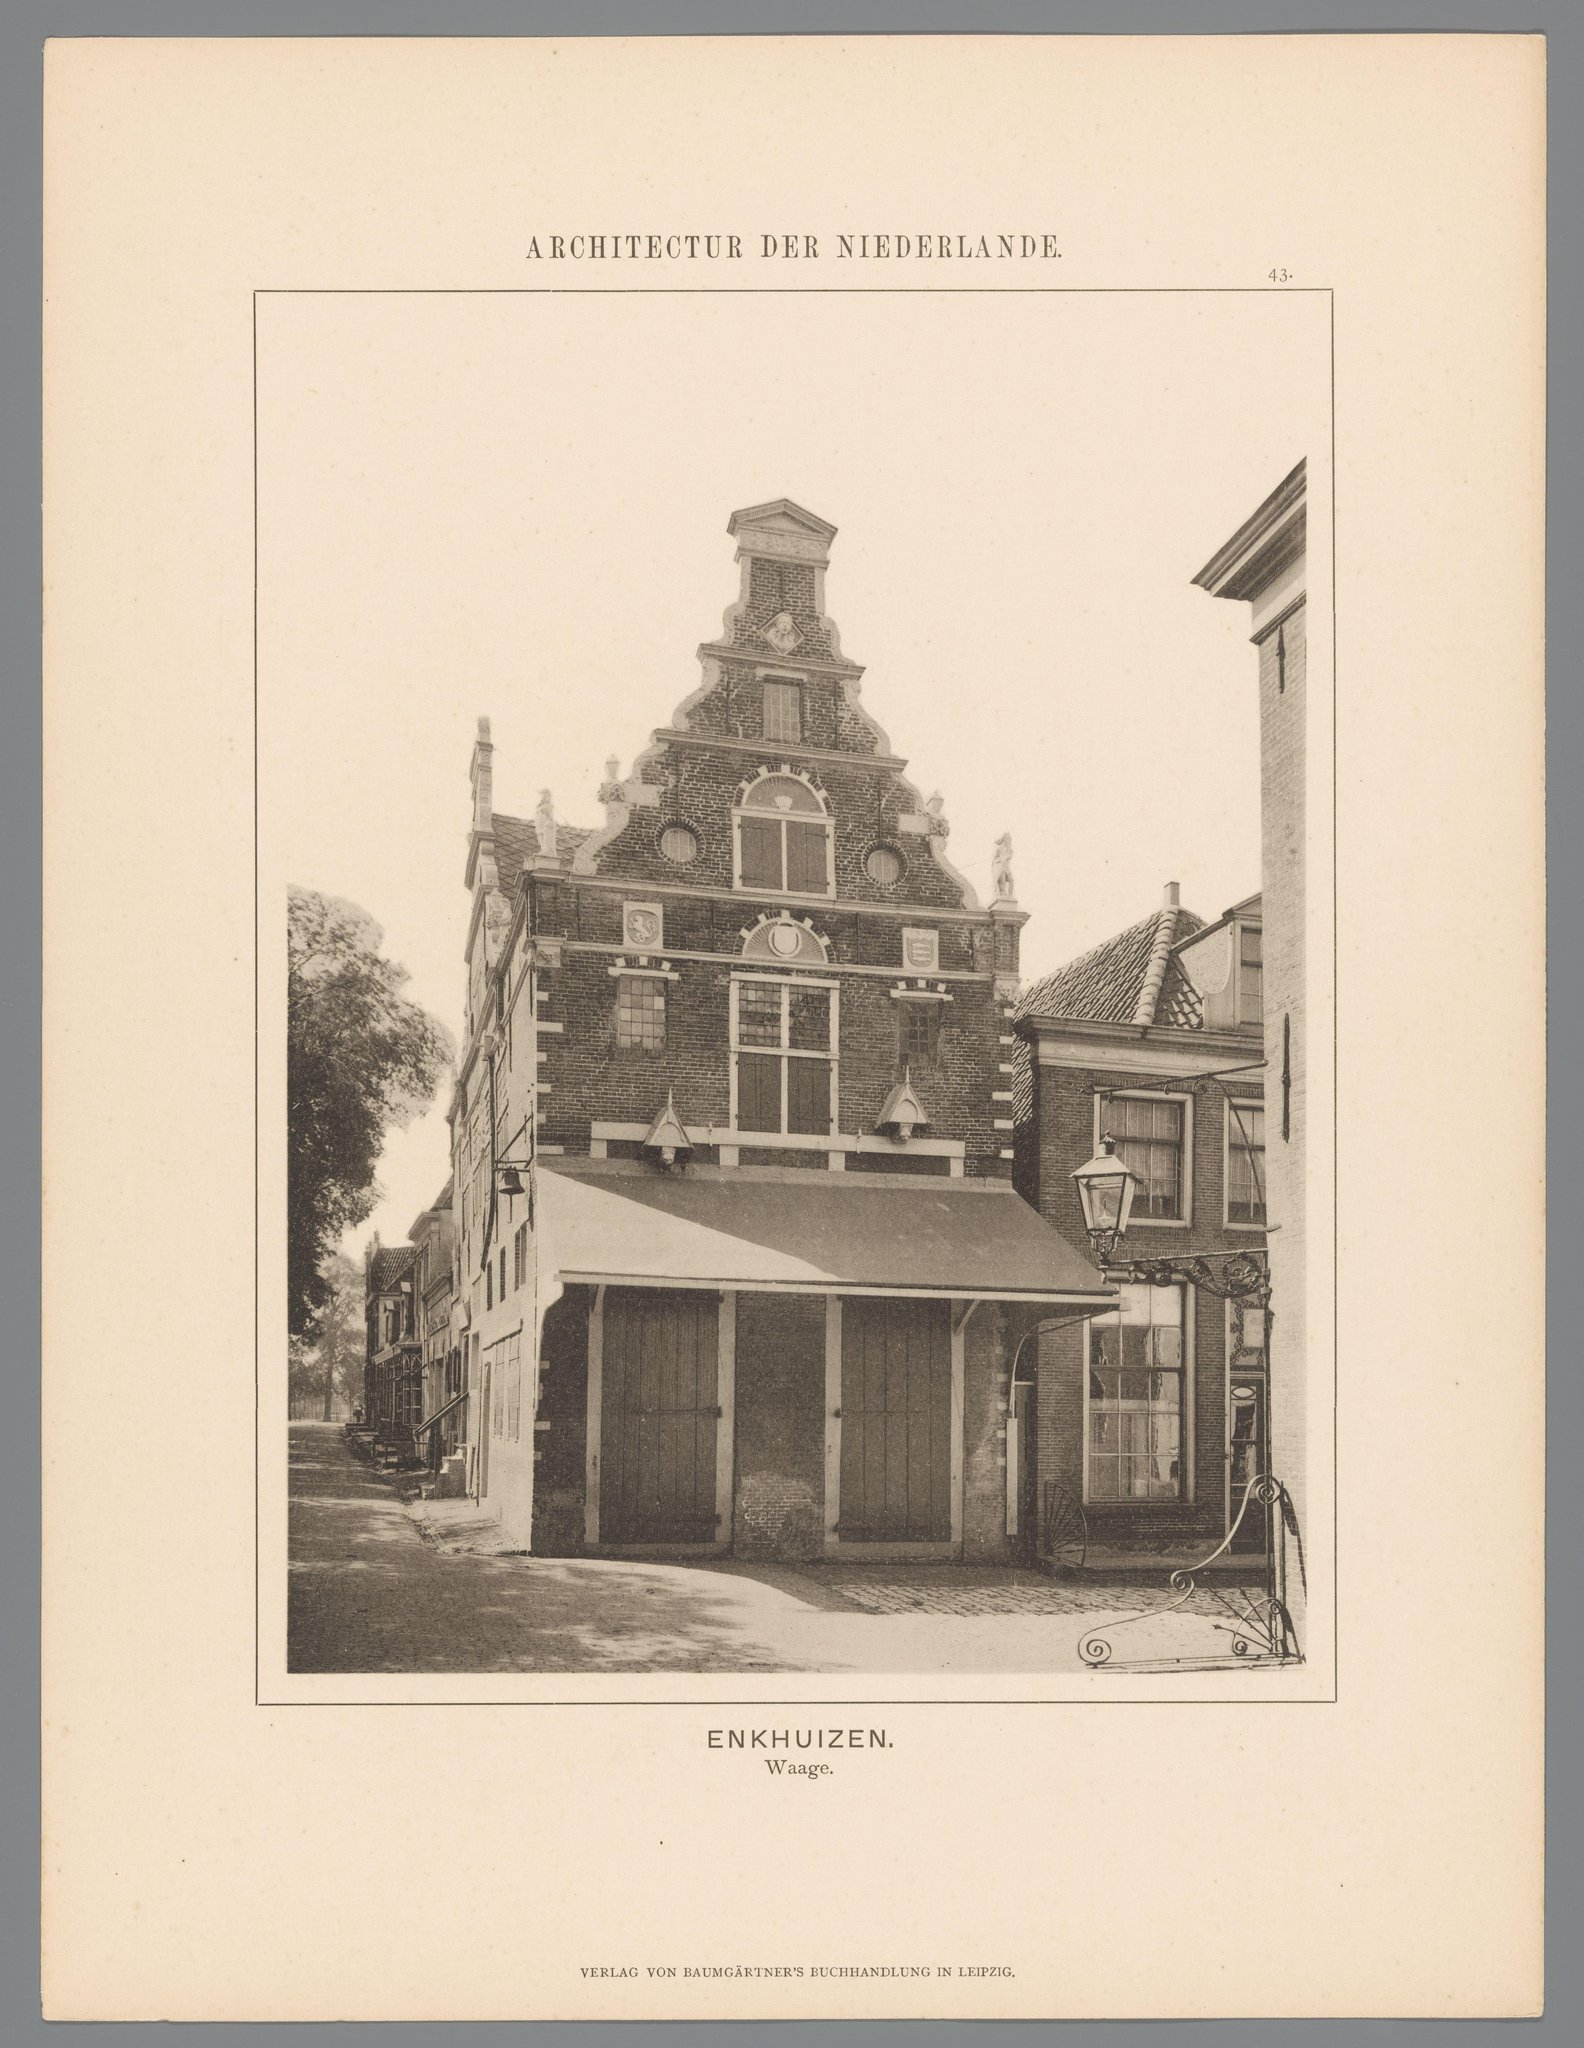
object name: photomechanical print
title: Architectuur in Nederland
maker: Anonymous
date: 1894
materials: paper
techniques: photograph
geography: enkhuizen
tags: weigh-house, enkhuizen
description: Afdruk uit: Krook, L. Architectur der Niederlande. Leipzig: Baumgärtner's Buchhandlung, 1894.